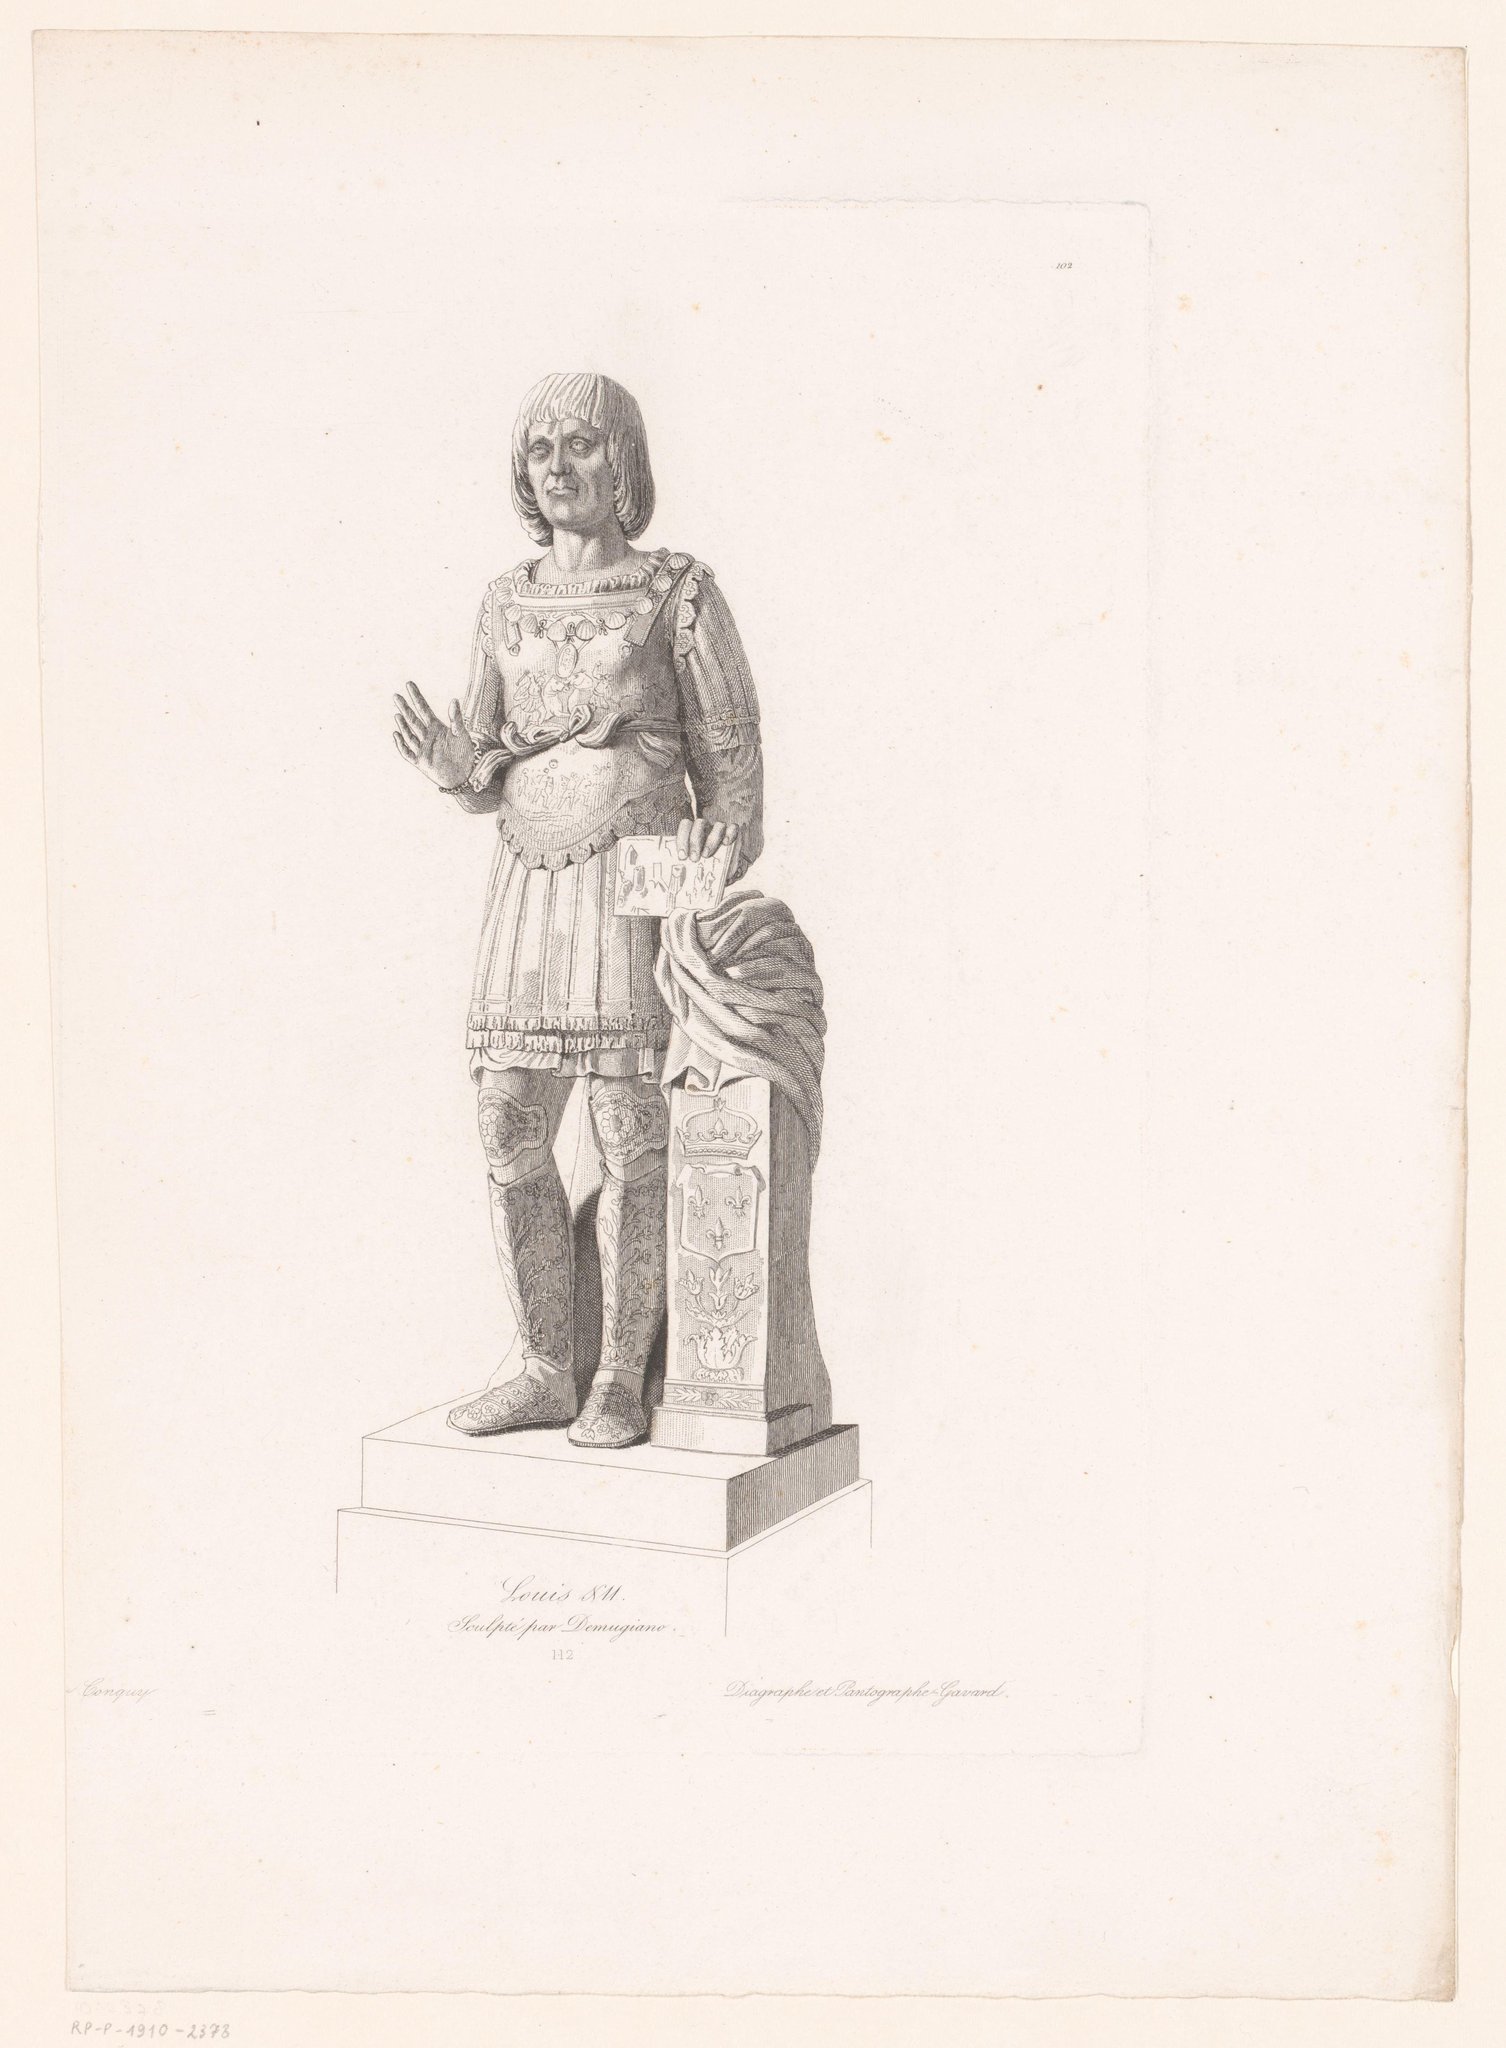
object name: print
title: Portret van Lodewijk XII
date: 1838-1841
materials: paper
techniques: engraving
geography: paris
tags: paris, historical persons, ruler, sovereign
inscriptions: collector's mark: Lugt 2228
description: Prent uit: Galeries historiques de Versailles. Parijs: Charles Gavard, 1838-1841.